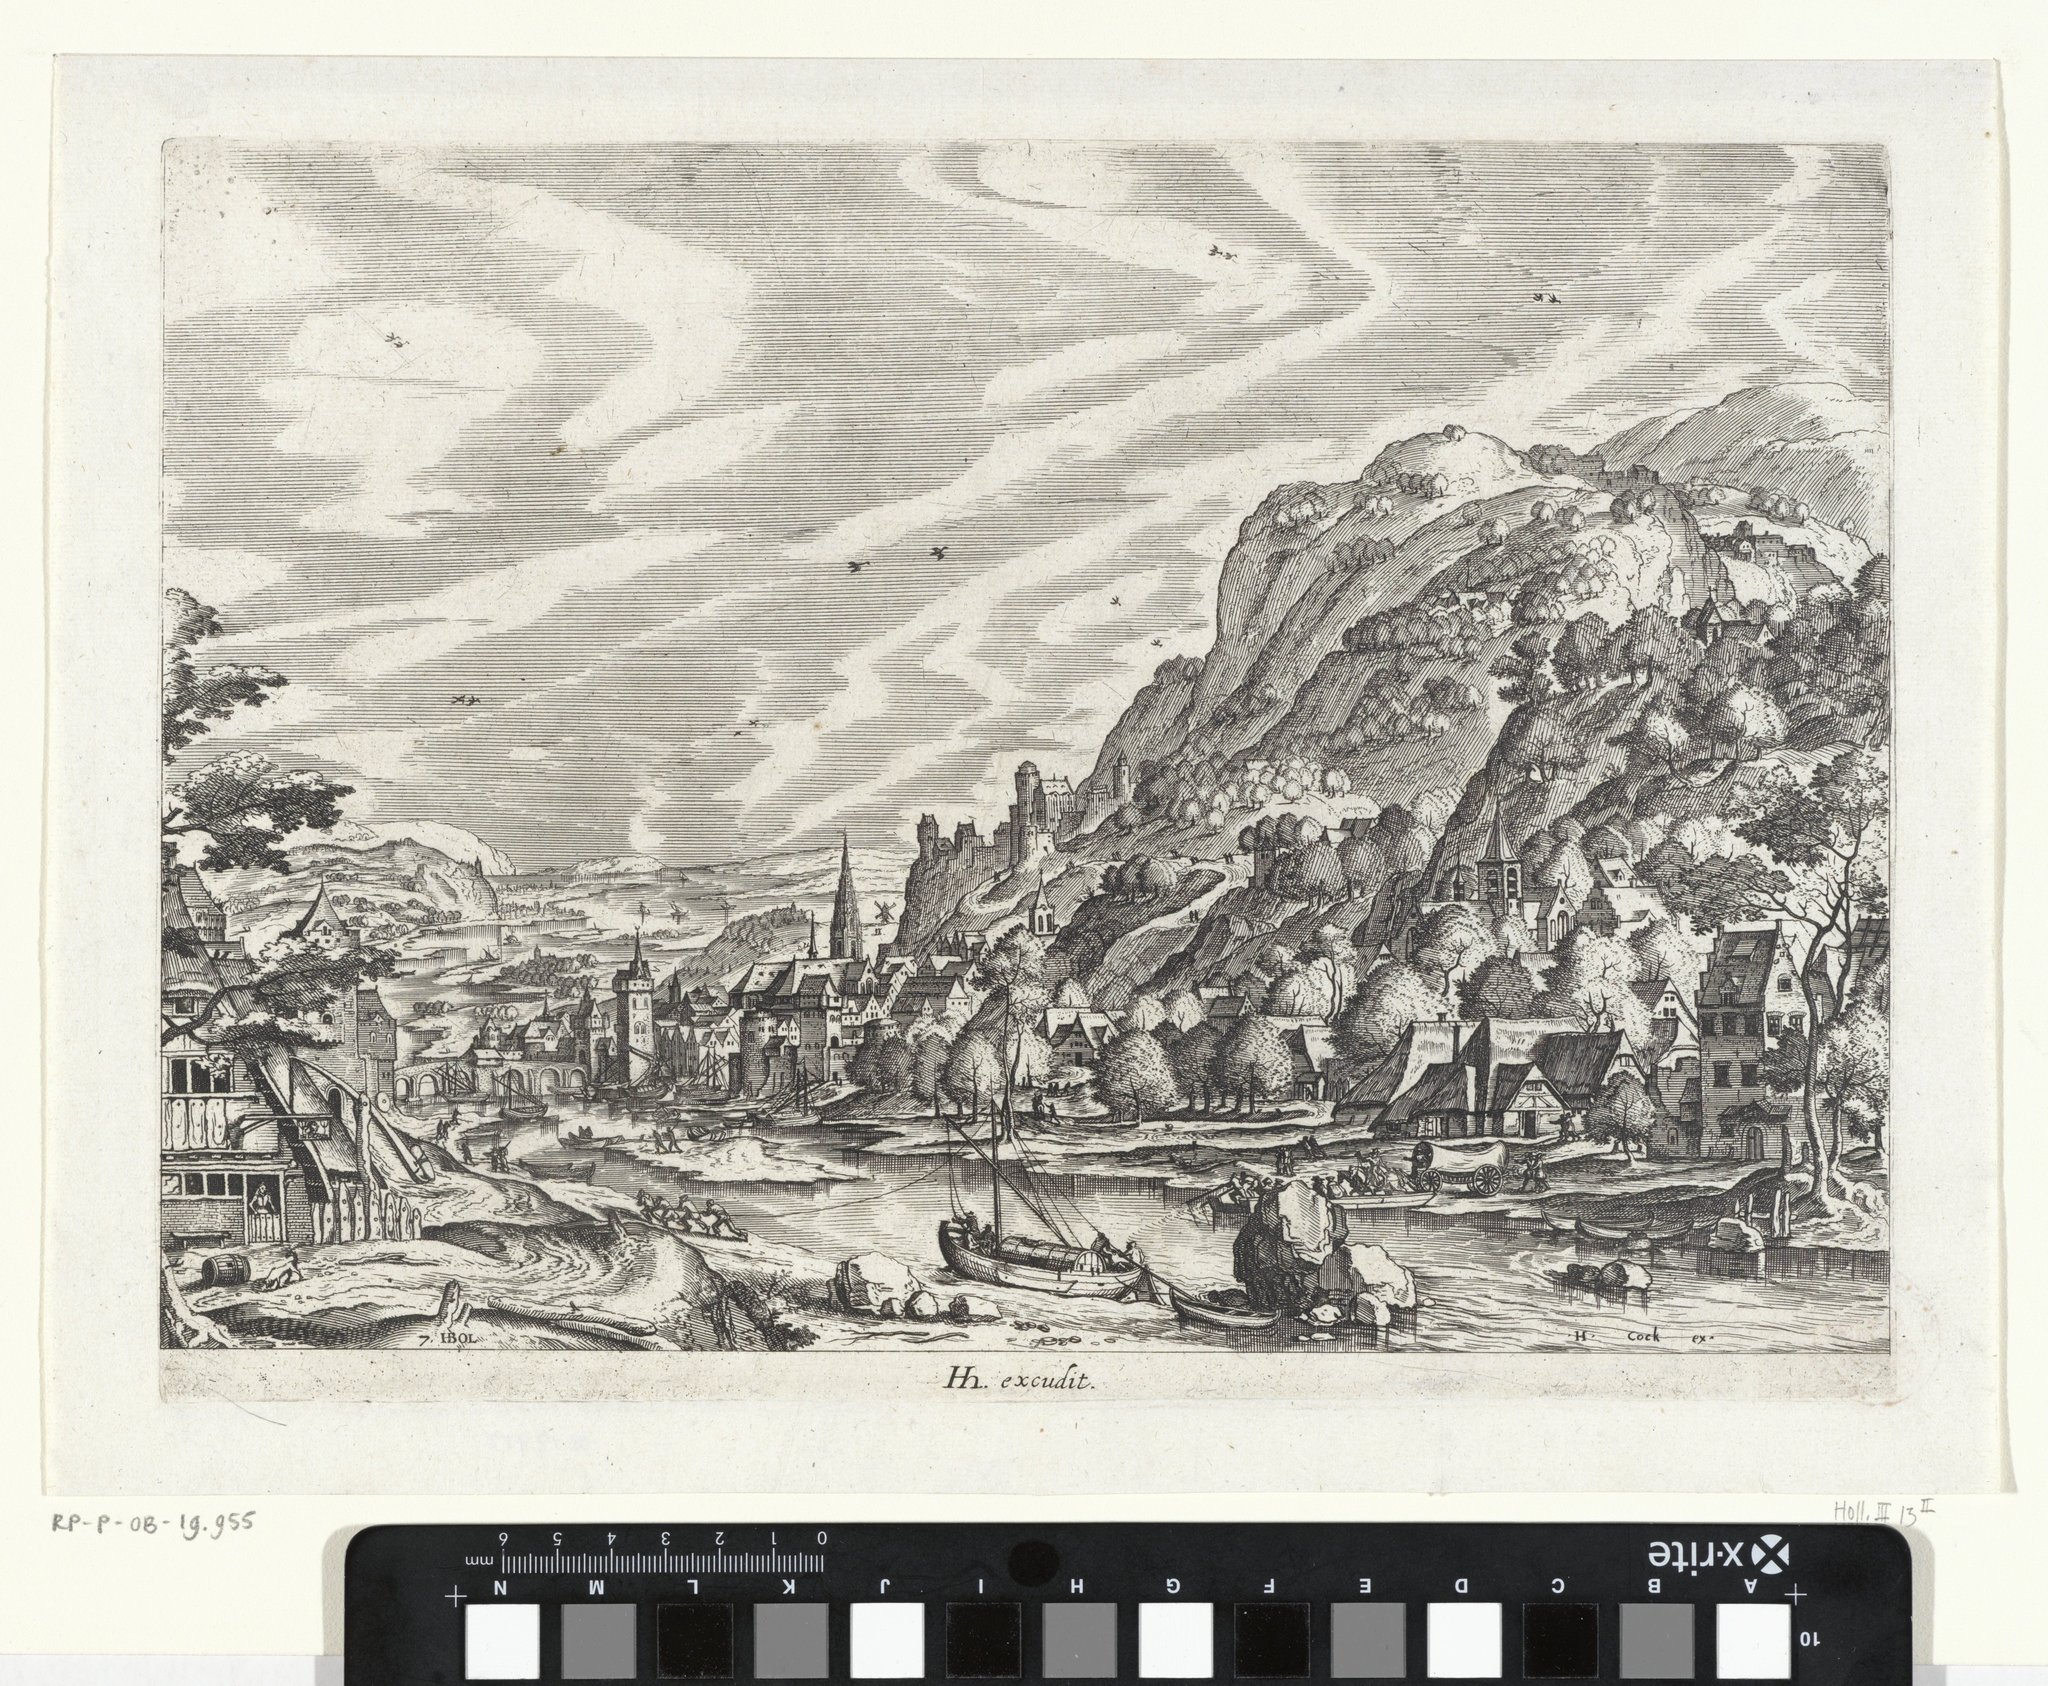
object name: print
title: Rivierlandschappen met bebouwing en figuren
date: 1597-1650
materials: paper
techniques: etching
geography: the hague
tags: ferry, tow-boat, towing-barge, river (+ landscape with figures, staffage), mountains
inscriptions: collector's mark: Lugt 240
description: Door een bergachtig landschap stroomt een rivier. Over de rivier varen een trekschuit en een pont. Beide oevers zijn bebouwd.